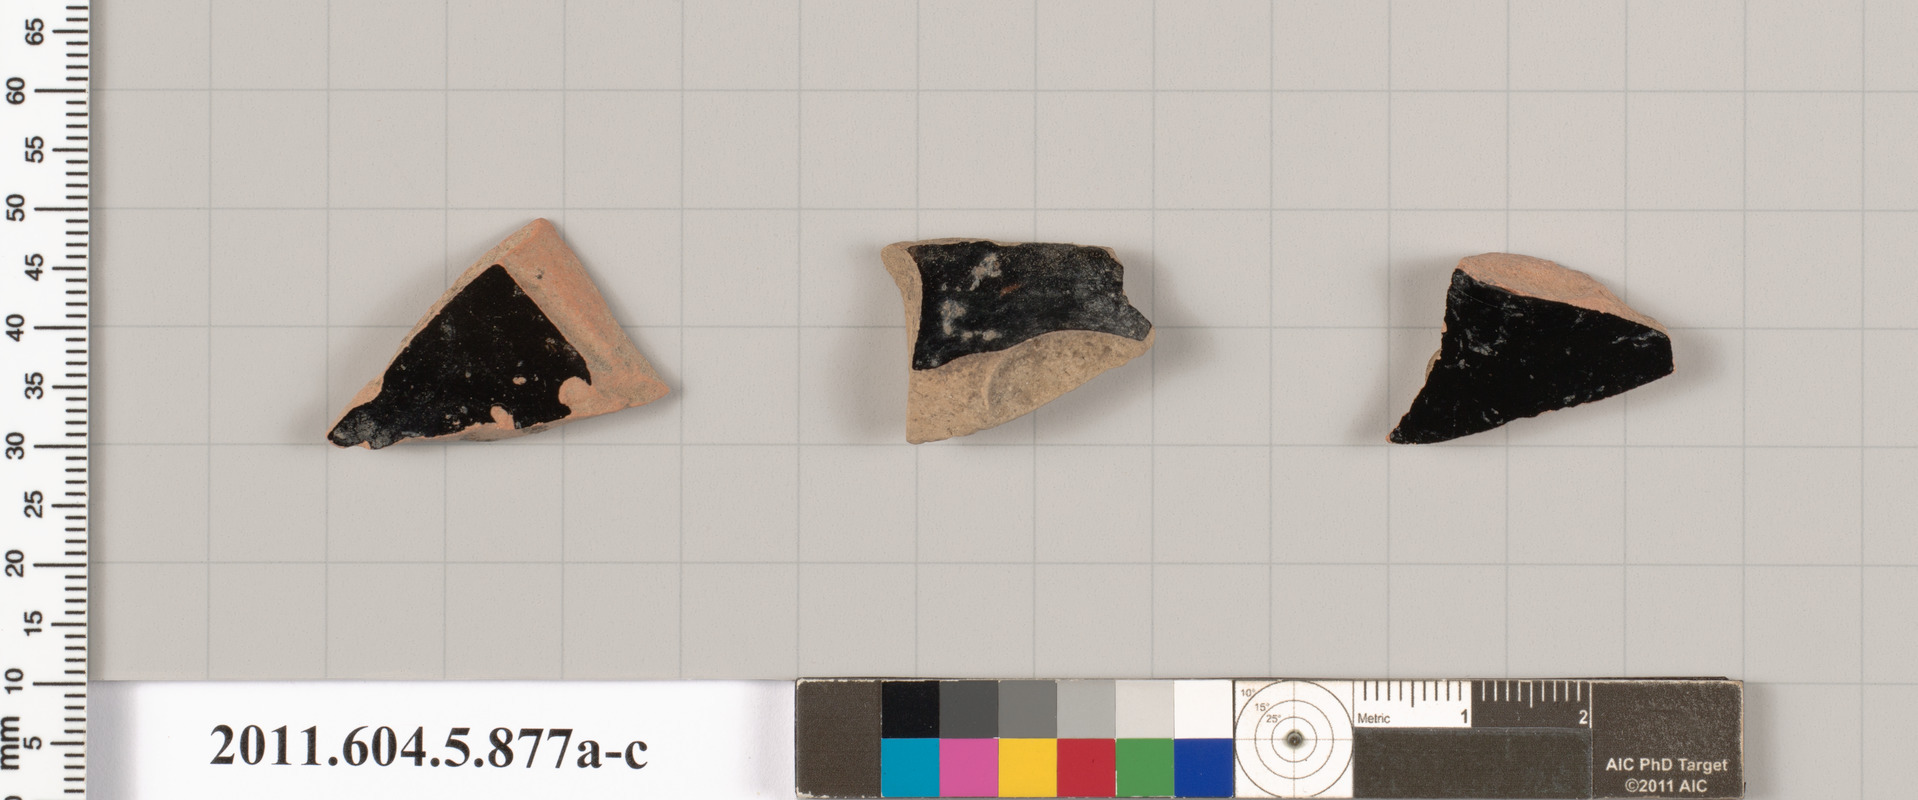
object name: kylix fragment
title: Terracotta fragments of kylikes (drinking cups)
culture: greek, attic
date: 600-401 BCE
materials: terracotta